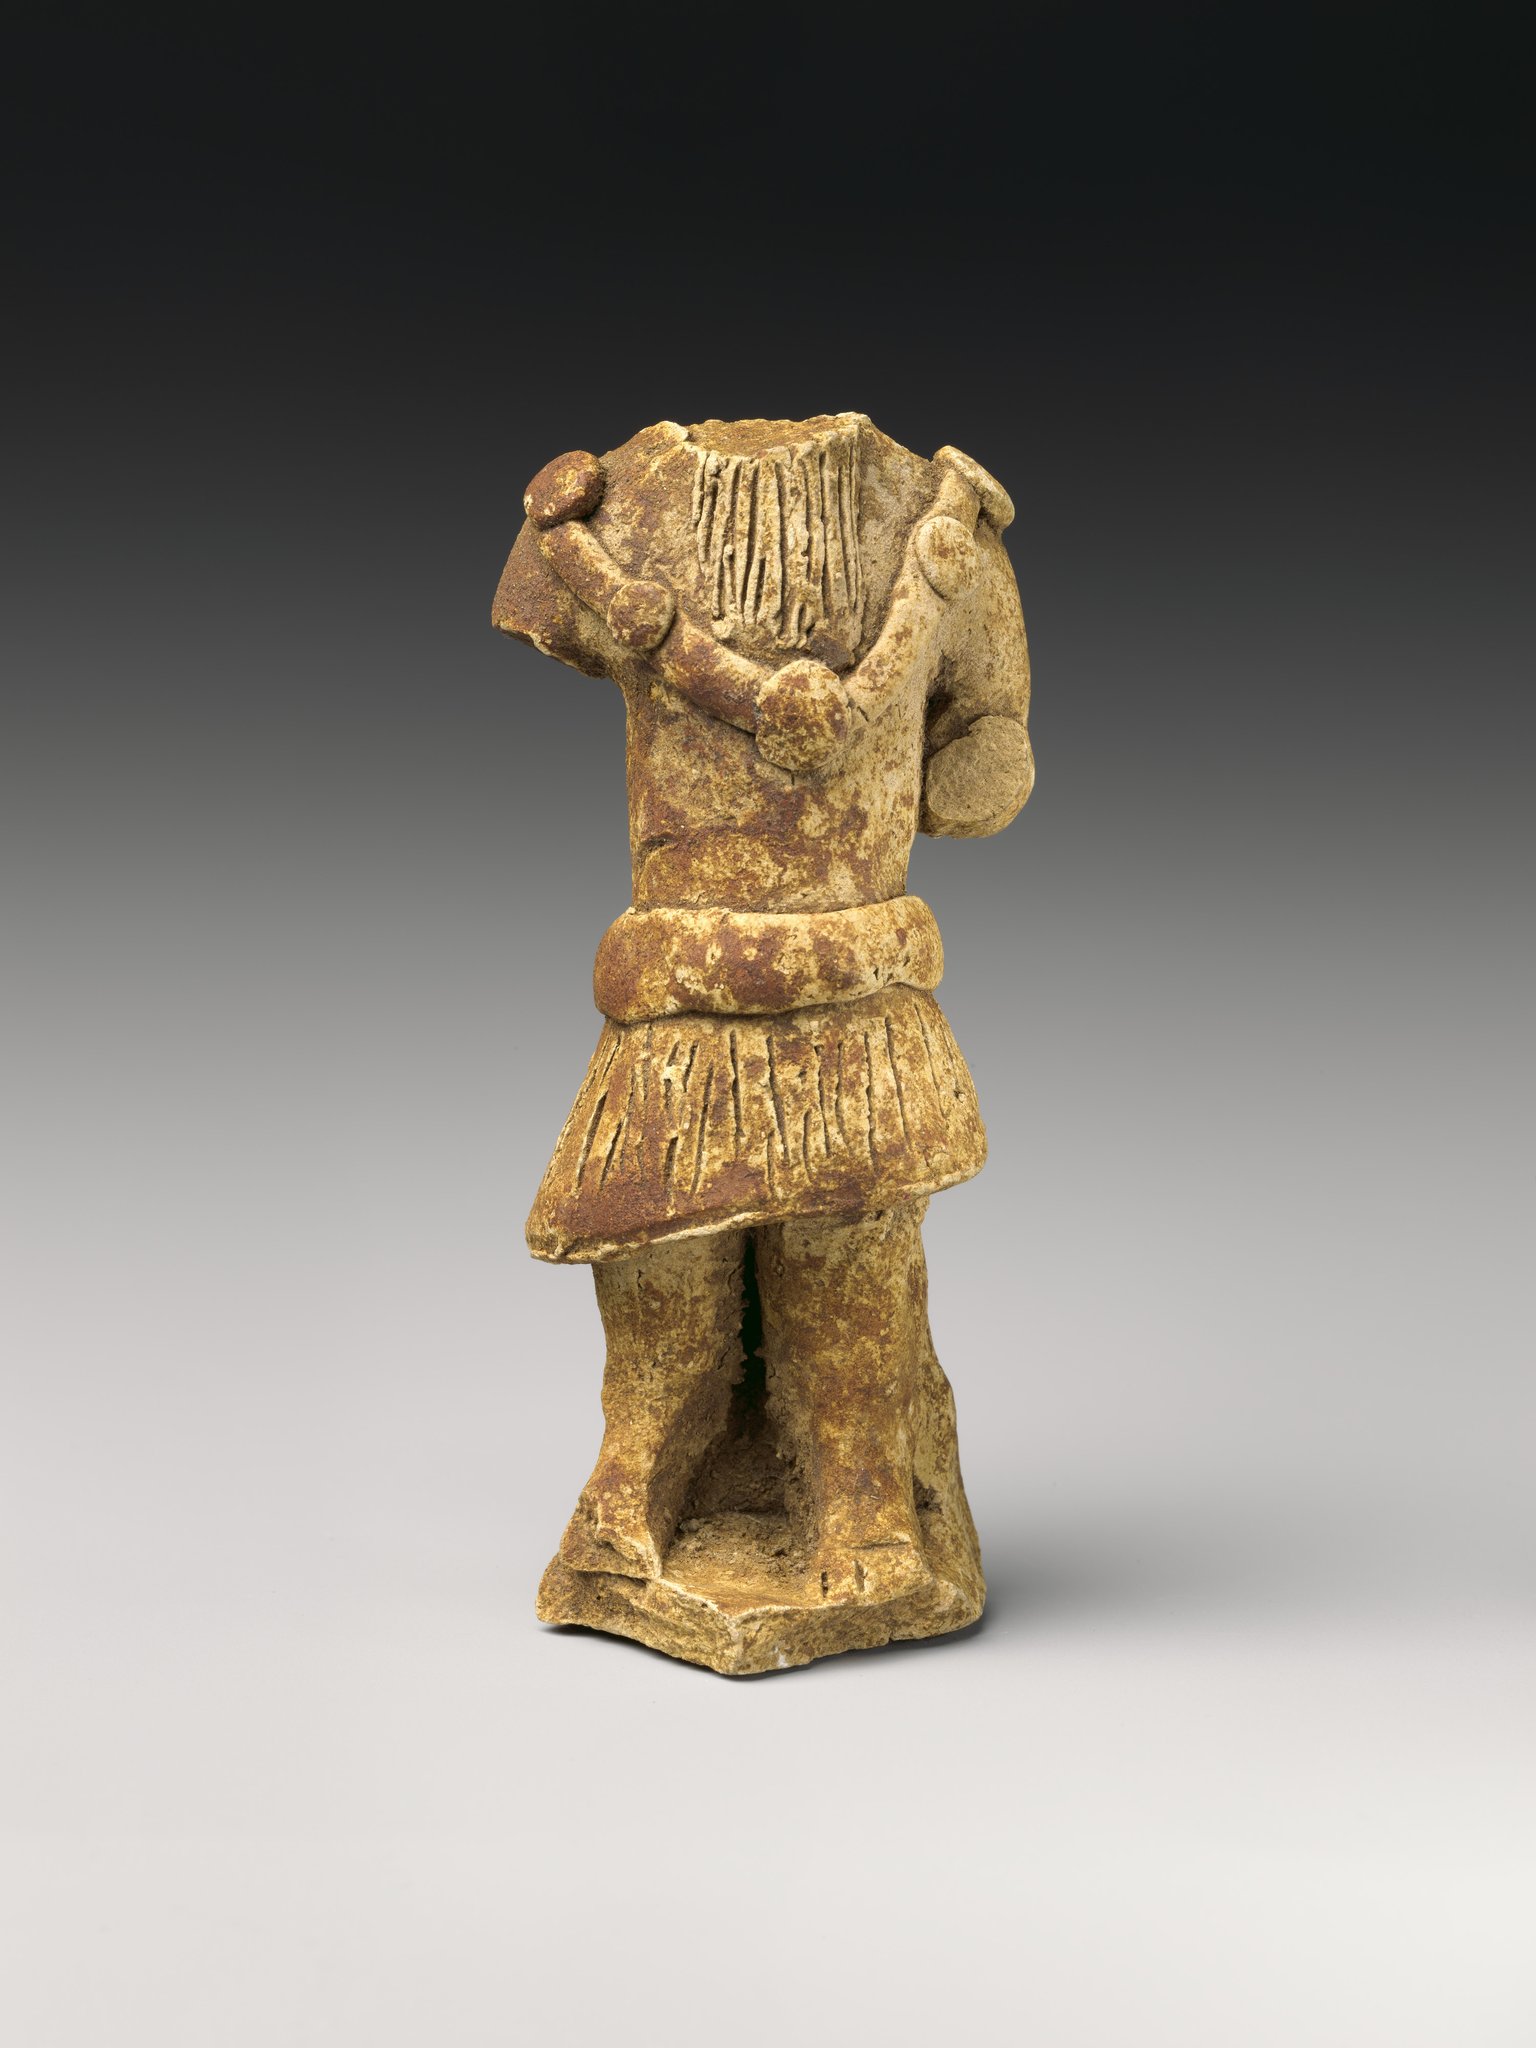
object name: sculpture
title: Figurine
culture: neo-sumerian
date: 2100-2000 BCE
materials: ceramic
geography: mesopotamia